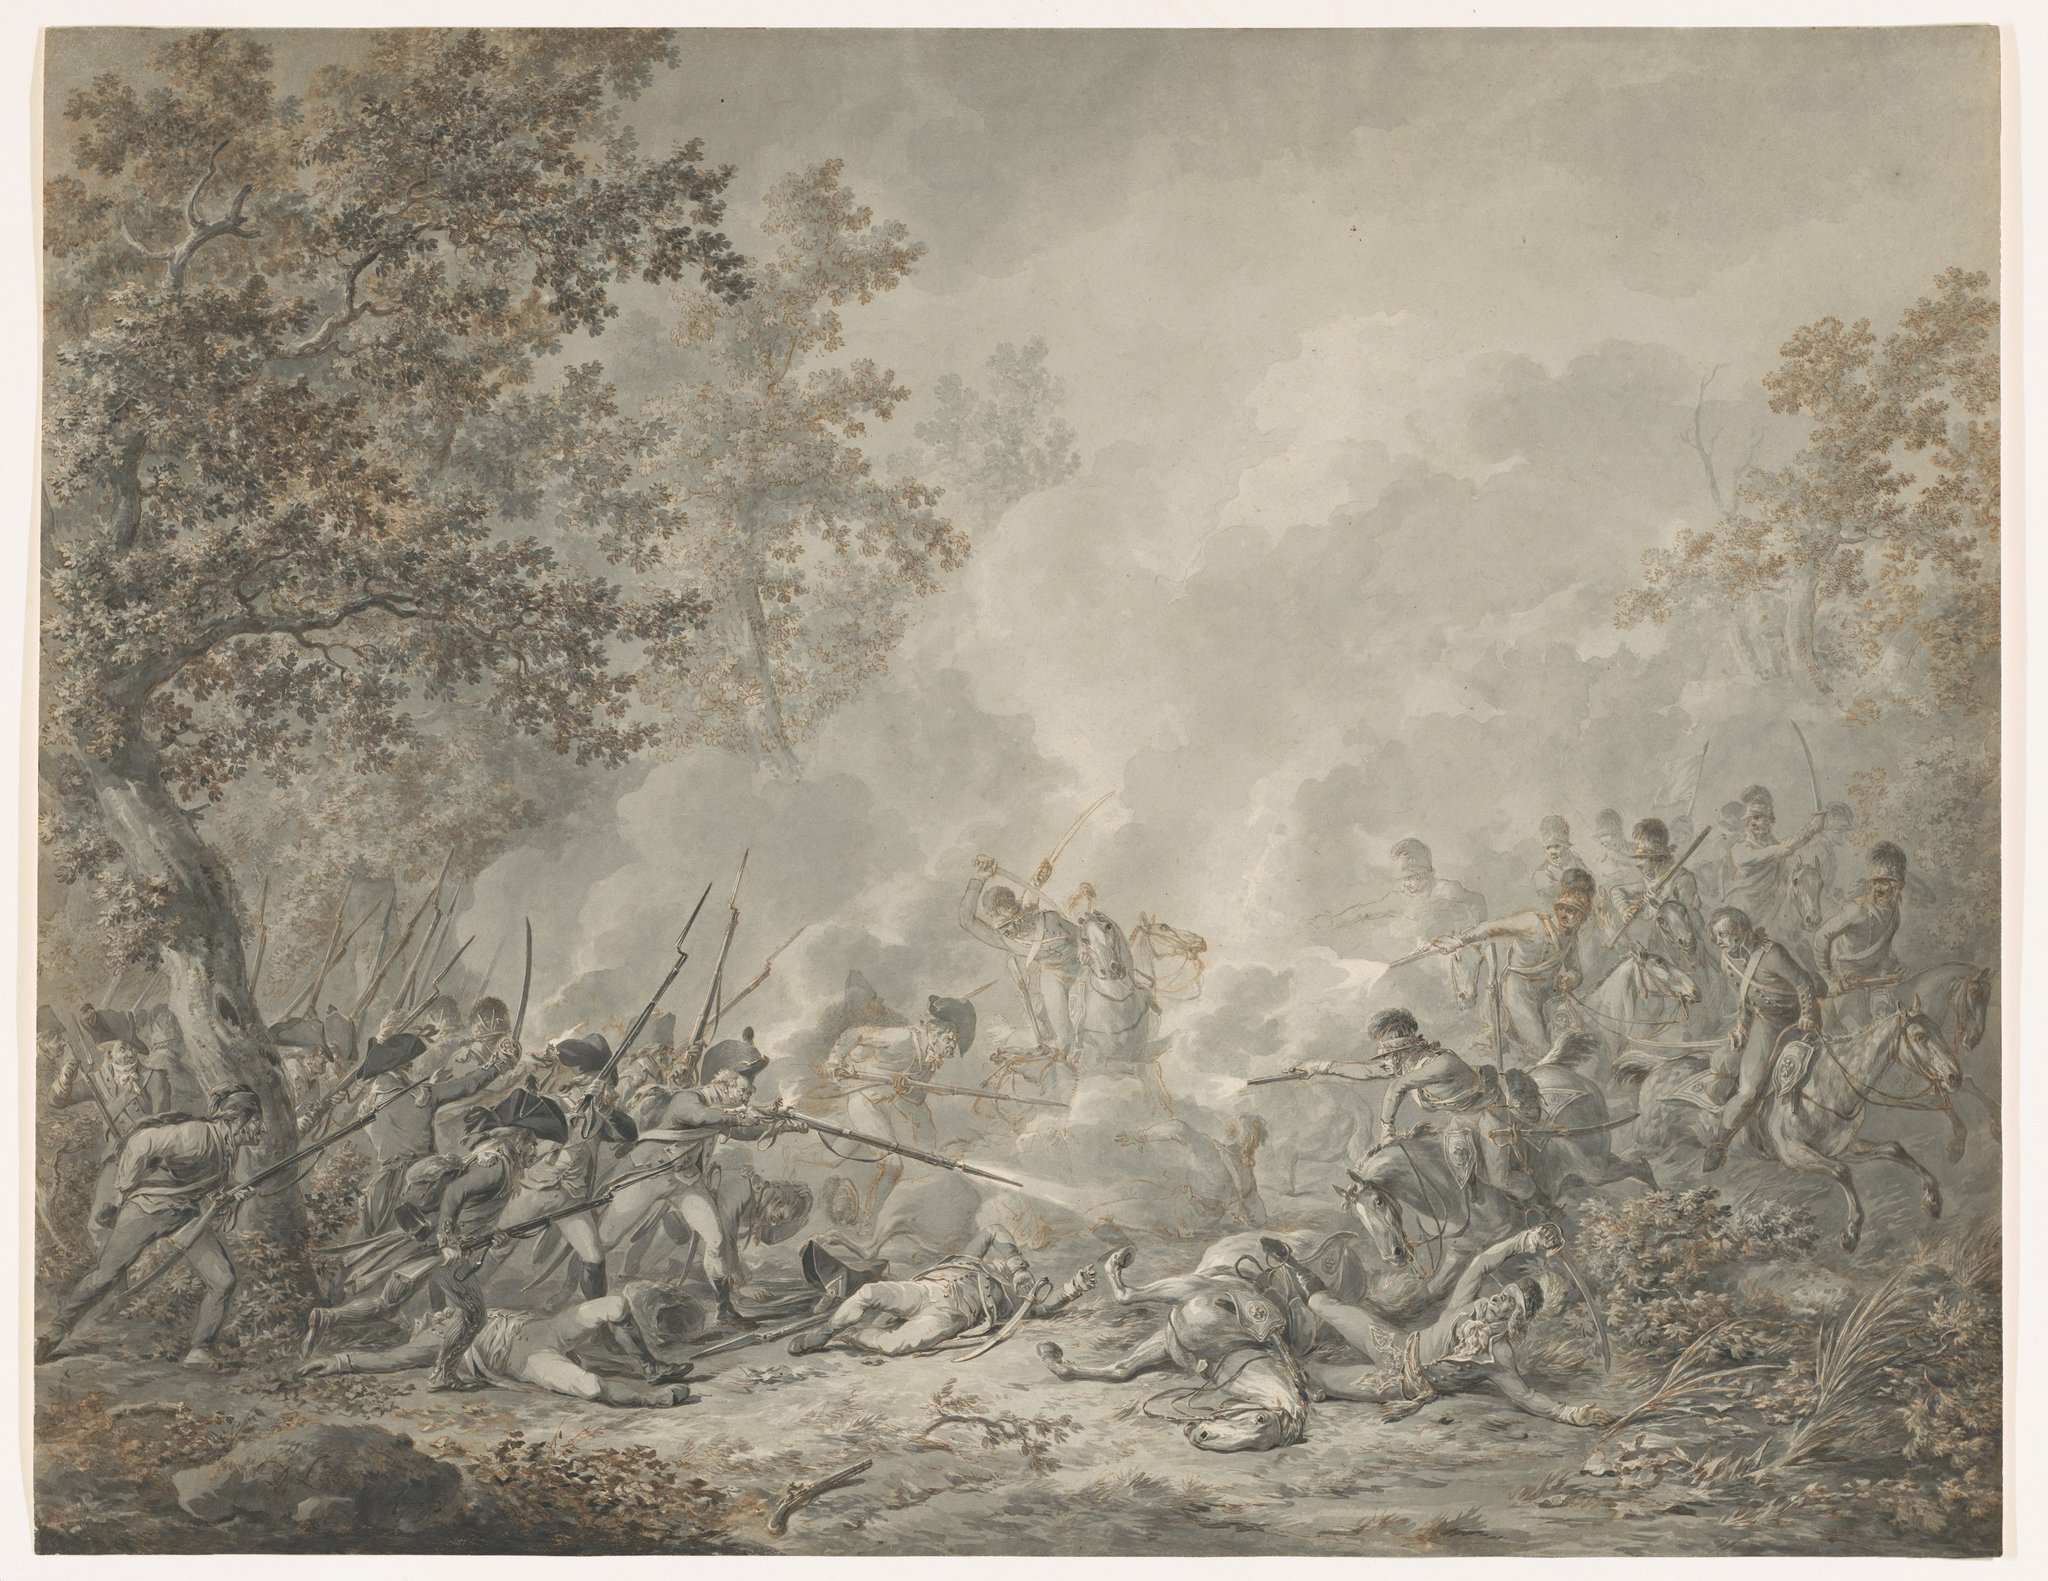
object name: drawing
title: A Battle Between Cavalrymen and Infantry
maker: dirk langendijk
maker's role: artist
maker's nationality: dutch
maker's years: 1748-1805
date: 1790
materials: ink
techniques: brush, pen, wash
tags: battles,soldiers,firearms